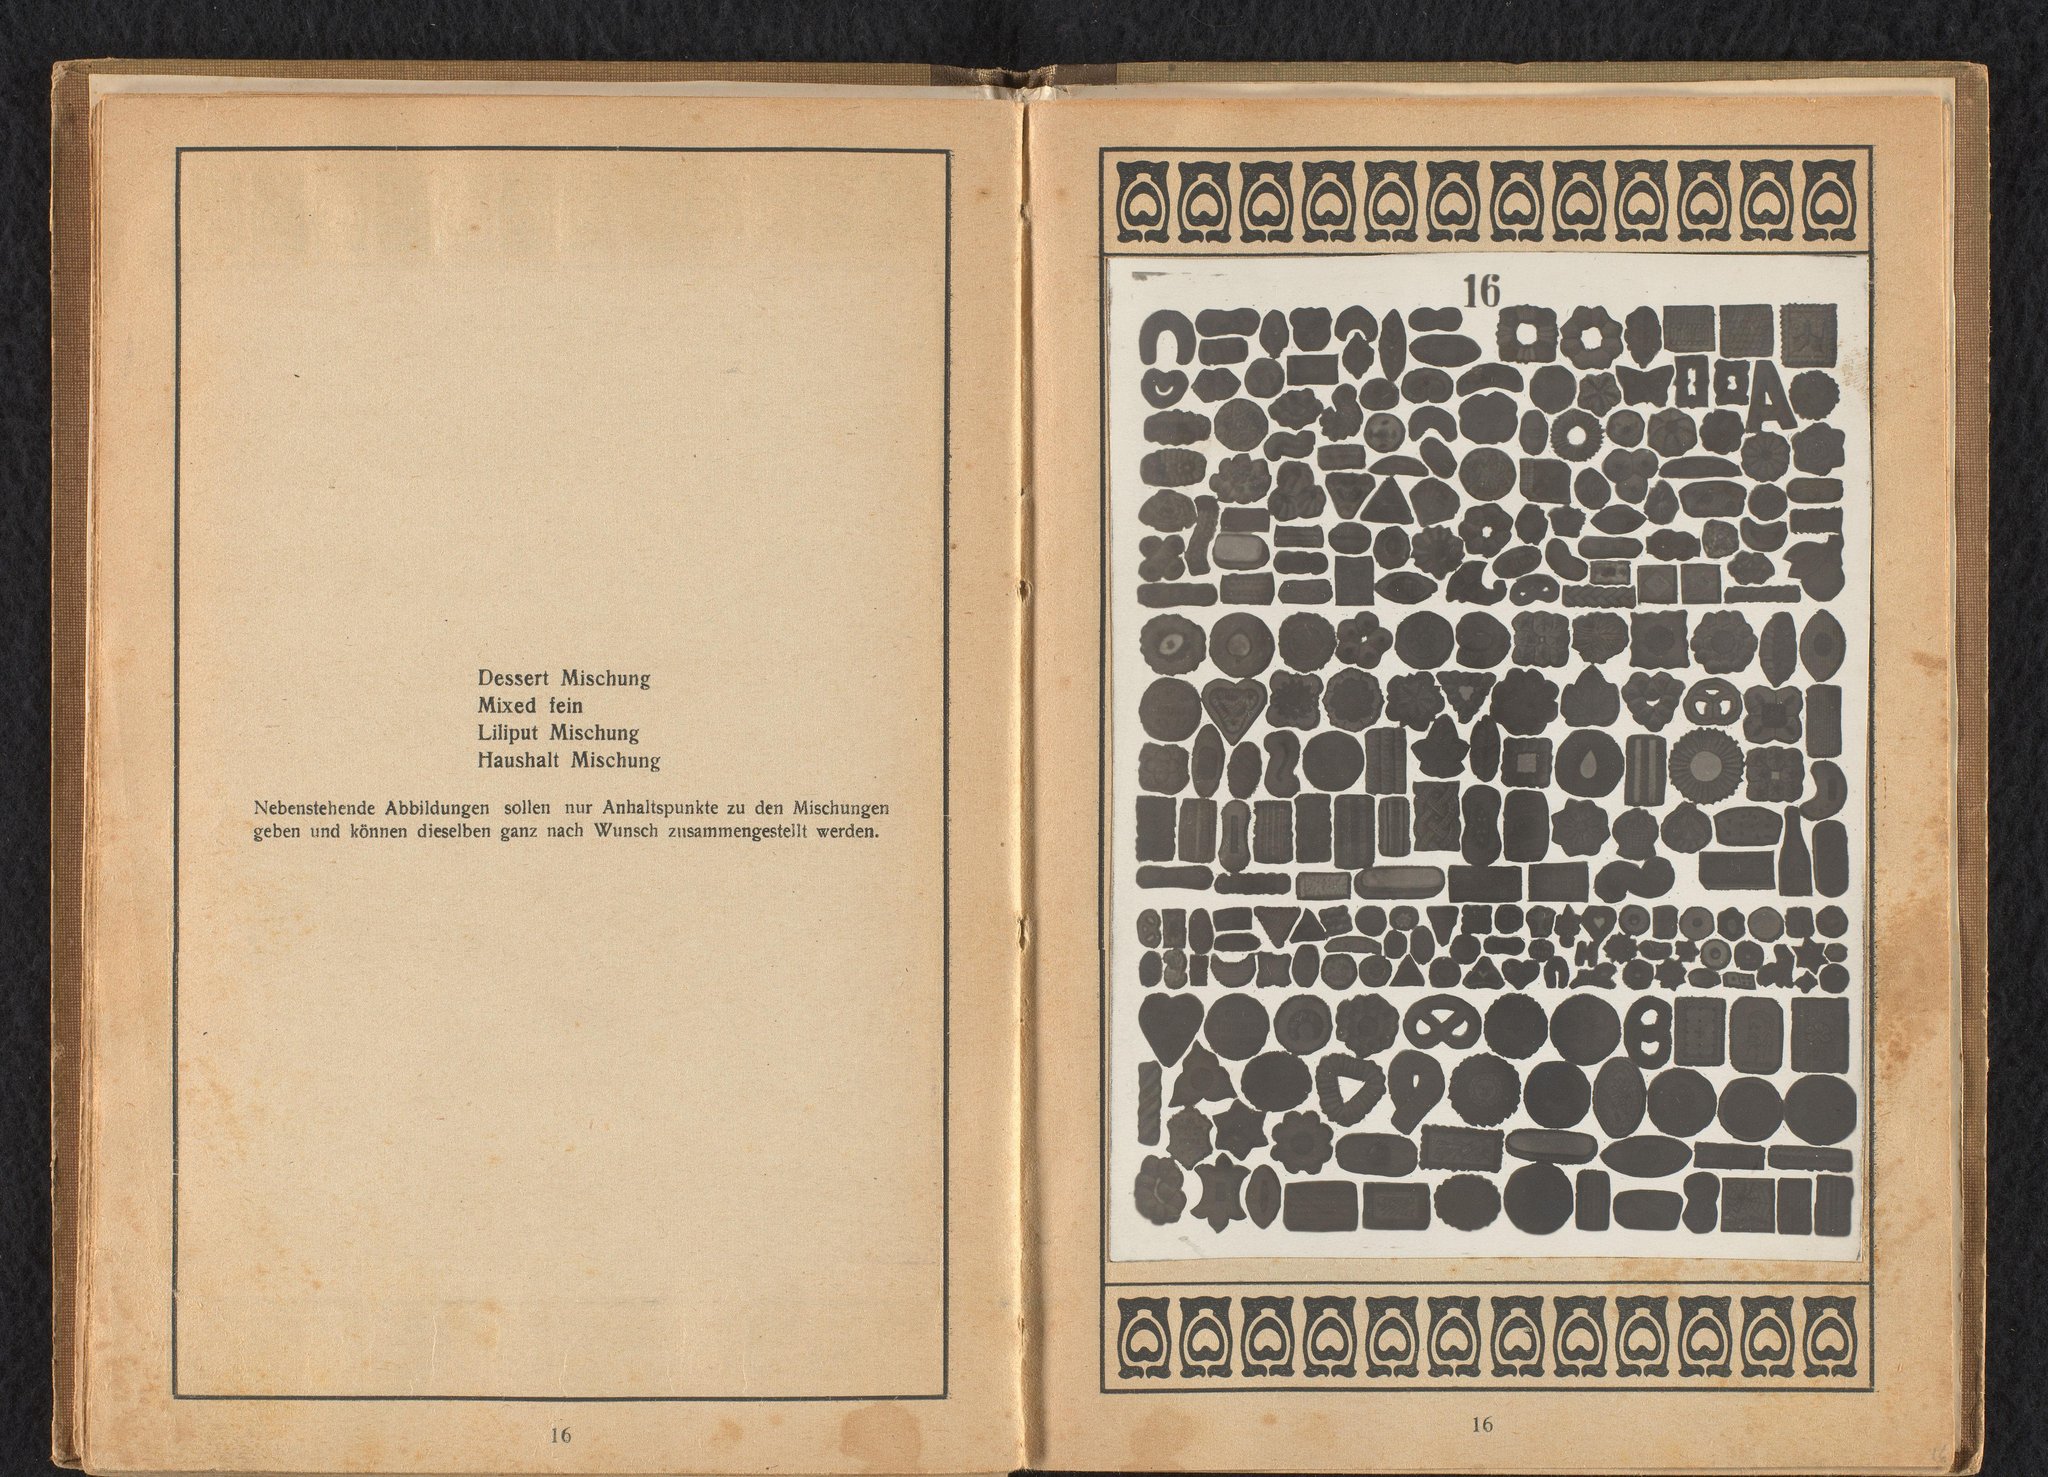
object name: photograph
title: Verschillende Engelse koekjes en biscuits als voorbeeld van diverse recepten voor het beslag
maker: Anonymous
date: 1900-1905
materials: paper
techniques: gelatin silver print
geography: bad langensalza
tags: pastry cook, moulds for biscuits, biscuits